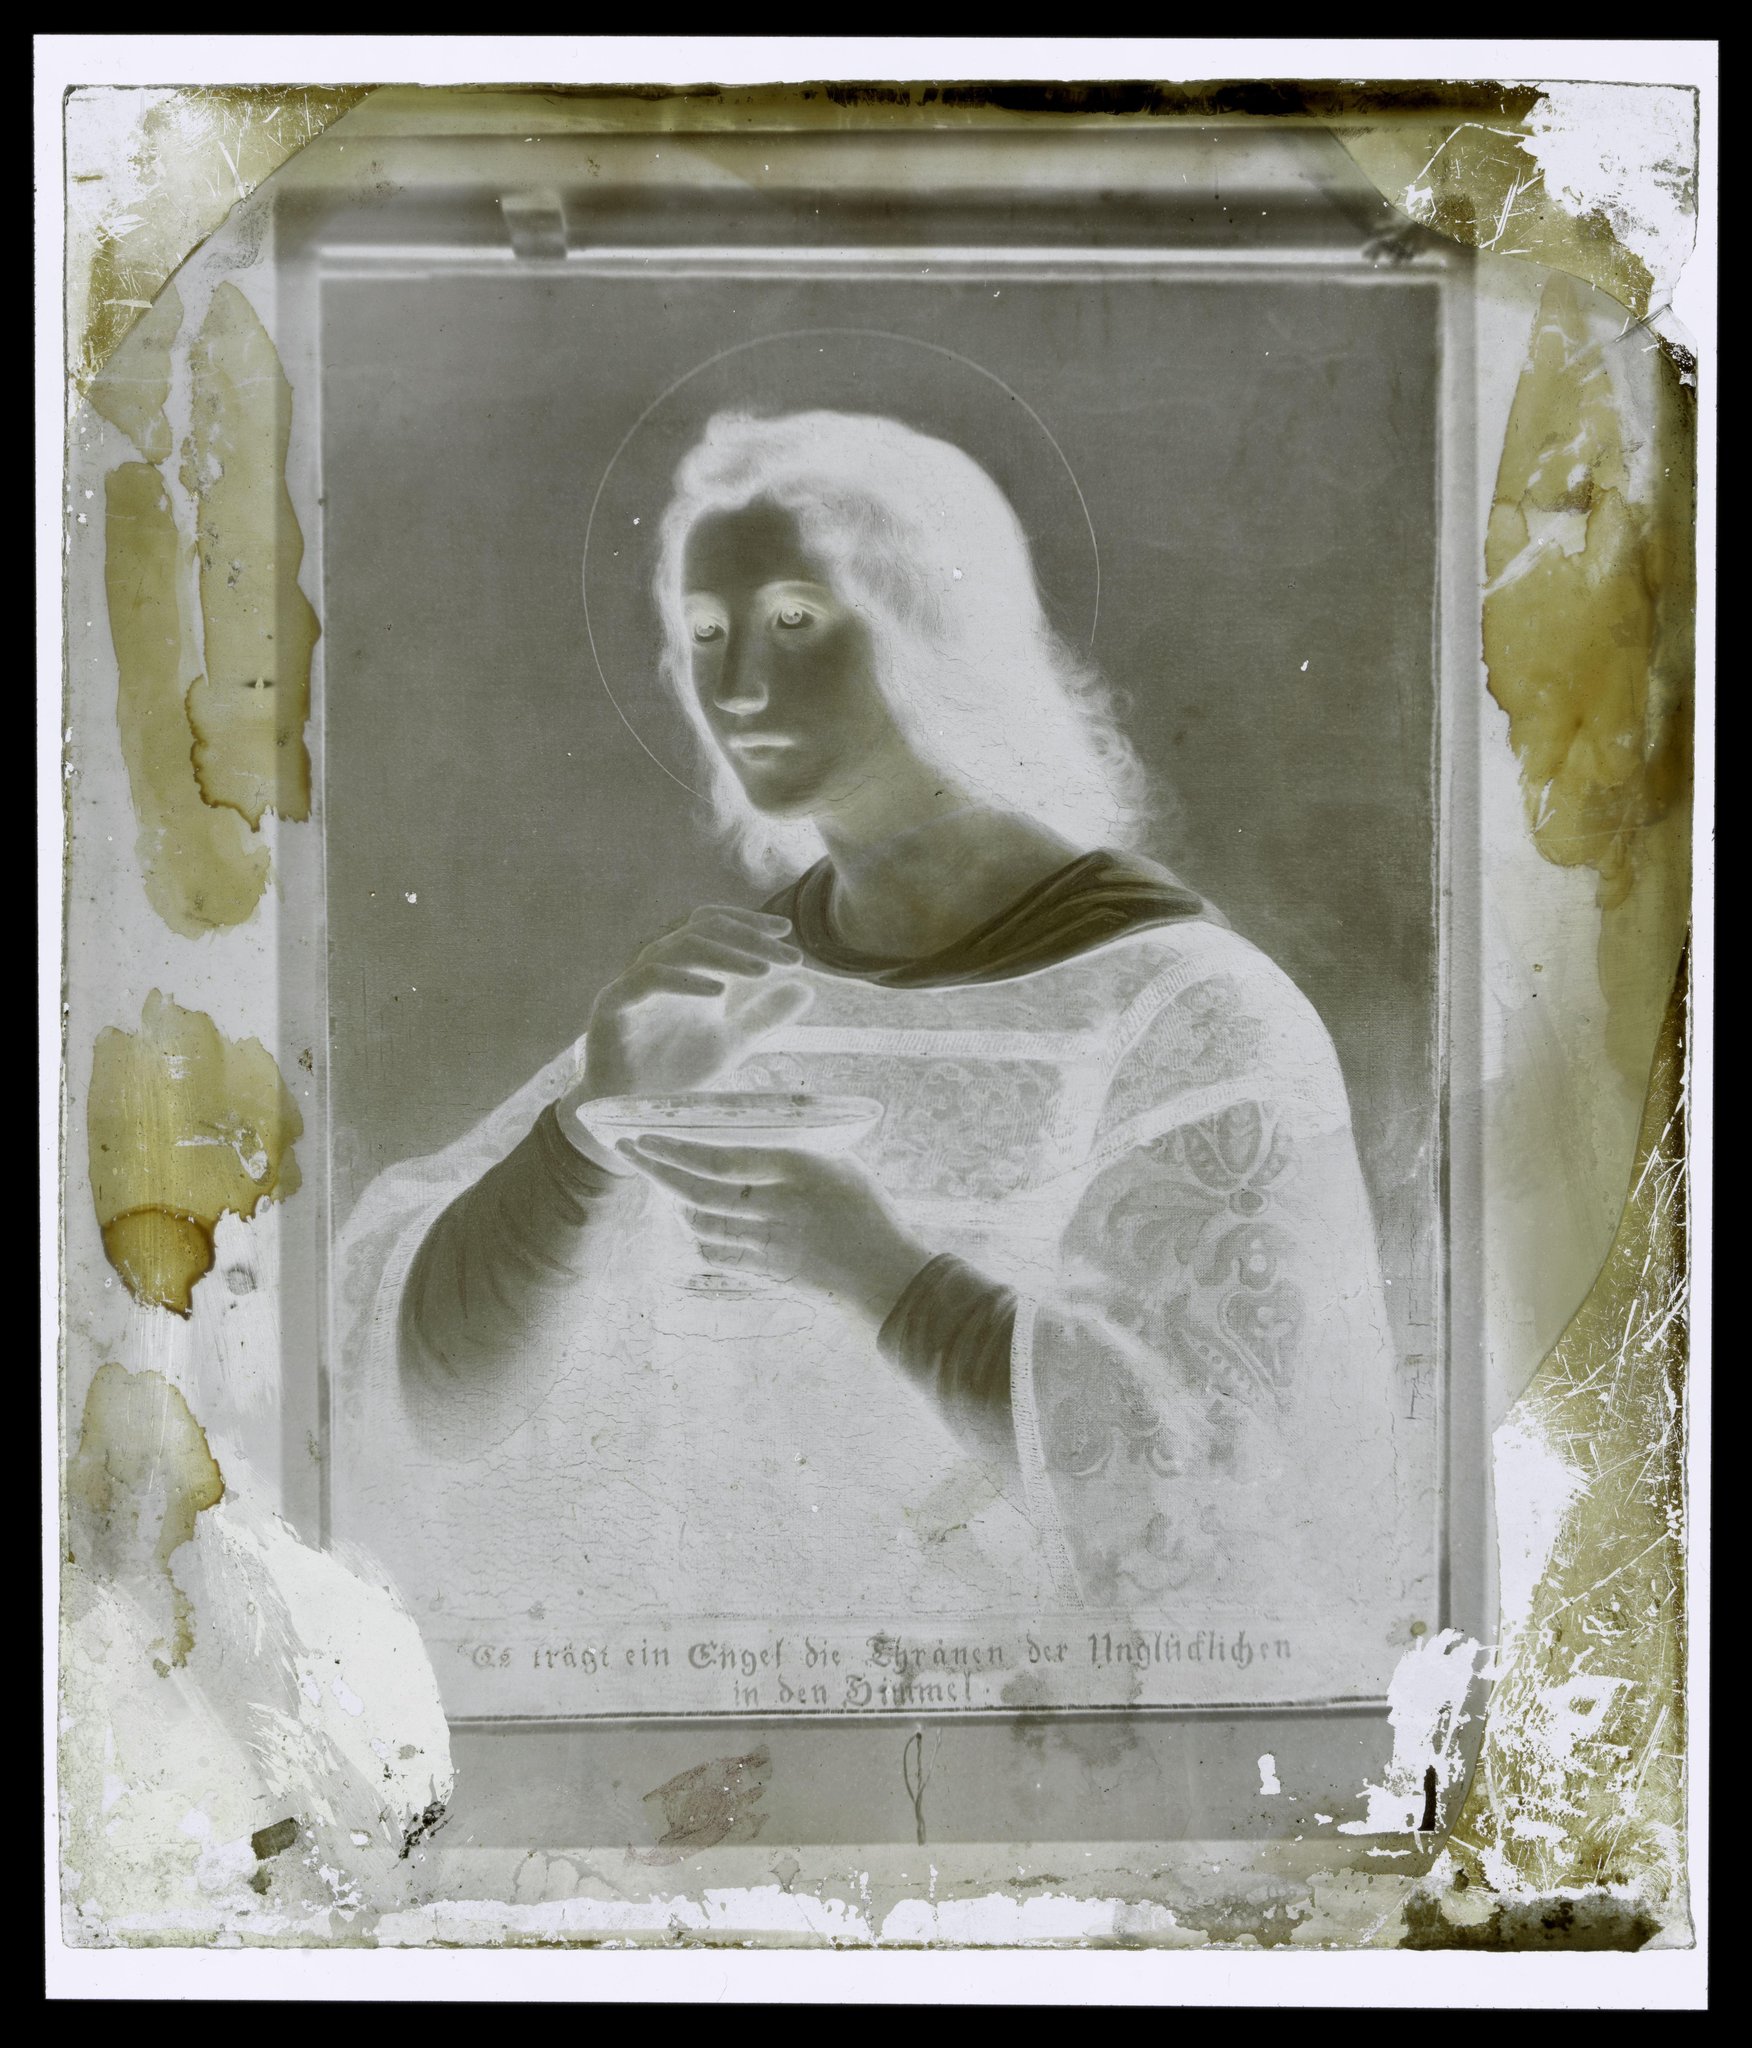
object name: reproduction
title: Fotoreproductie van een geschilderd portret van een onbekende heilige met drinkglas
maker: laurens lodewijk kleijn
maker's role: draughtsman, painter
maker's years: 1826-1909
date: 1865-1900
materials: glass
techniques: collodion process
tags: saints, glass, rummer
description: Onderdeel van een groep glasnegatieven uit de nalatenschap van de schilder Laurens Lodewijk Kleijn, met stillevens, portretten, zelfportretten en kunstreproducties.